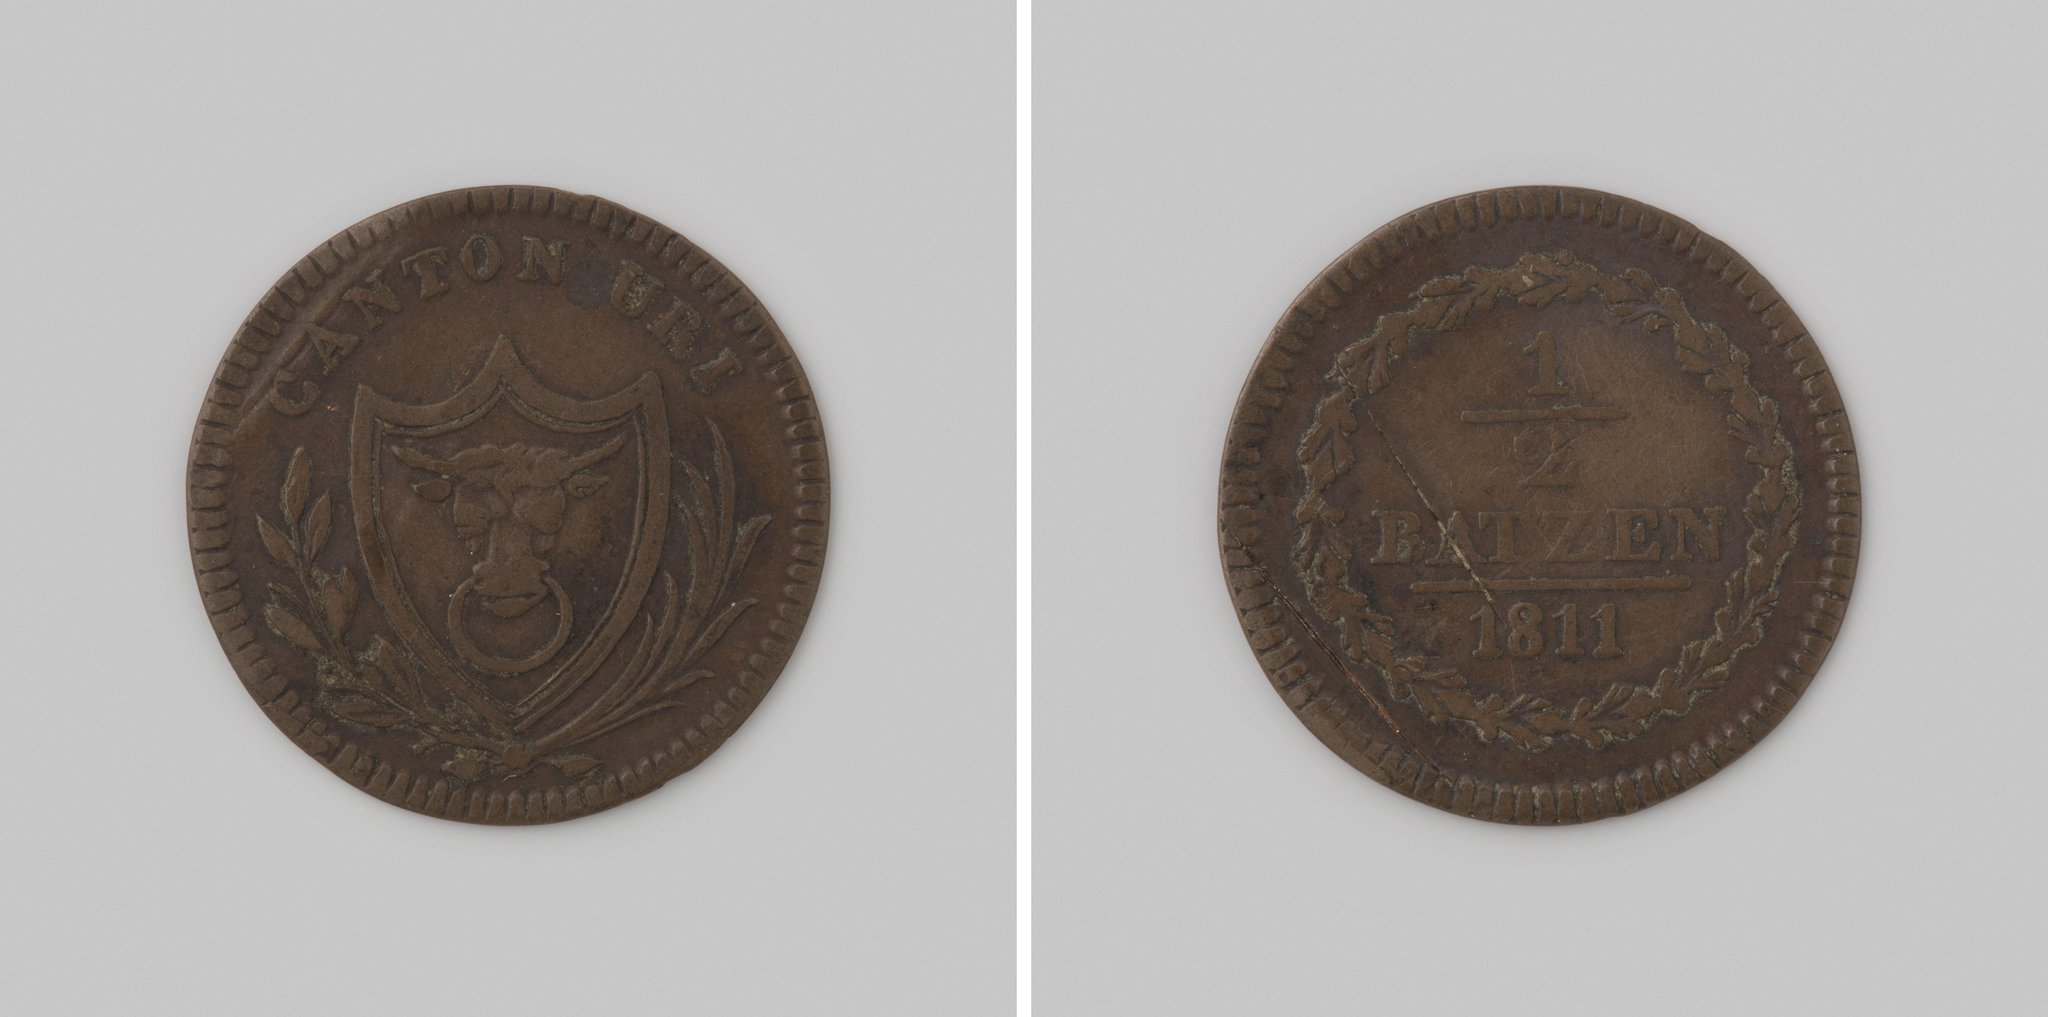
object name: coin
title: ½ batzen uit het kanton Uri, 1811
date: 1811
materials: copper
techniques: striking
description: Koperen munt. Voorzijde: tussen twee samengebonden takken wapenschild. Keerzijde: binnen krans van bladeren in twee regels waarde-aanduiding, waaronder jaartal. Gladde rand.